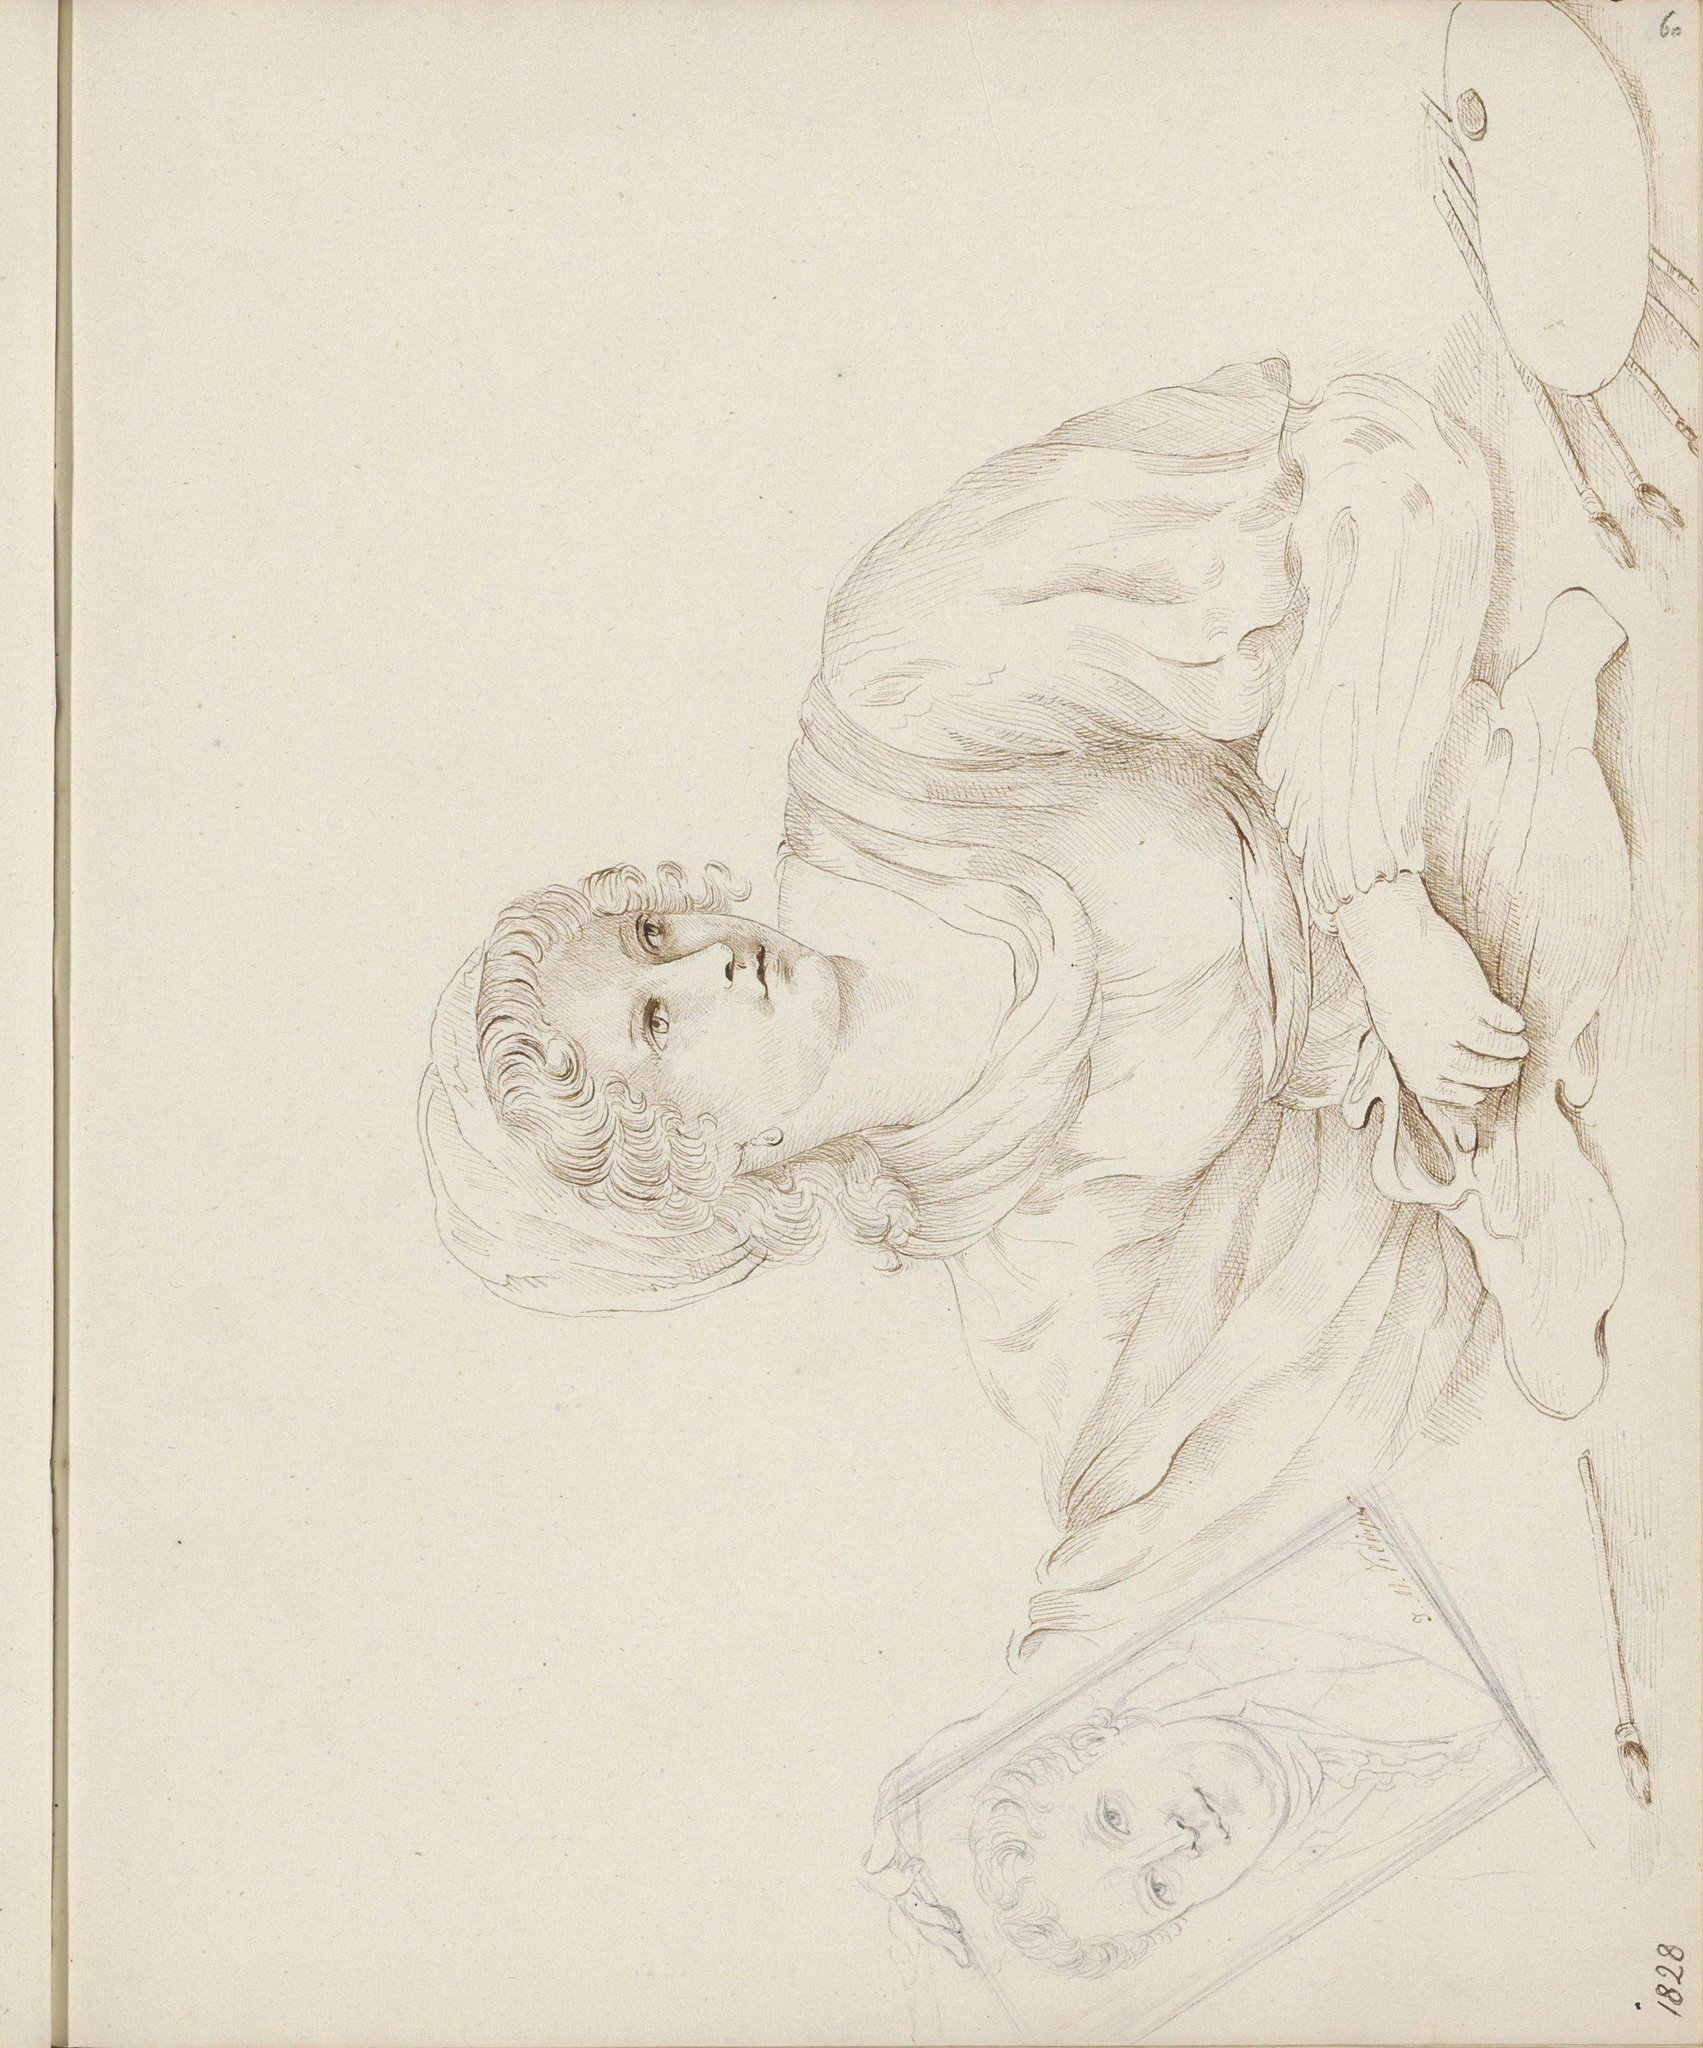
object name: sketchbook leaf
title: Zelfportret met schildersbenodigdheden en portret van jonkheer Joan Melchior Kemper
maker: jonkvrouw elisabeth kemper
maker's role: draughtsman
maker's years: 1799-1871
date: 1828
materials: ink, paper, pencil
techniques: pen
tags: leiden, jonkheer joan melchior kemper, draughtsman, jonkvrouw elisabeth kemper, picture within picture, portrait, self-portrait of artist, palette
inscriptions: annotation: ‘J.M. Kemper’, date: ‘1828’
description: Jonkheer Joan Melchior Kemper was de vader van de kunstenares.